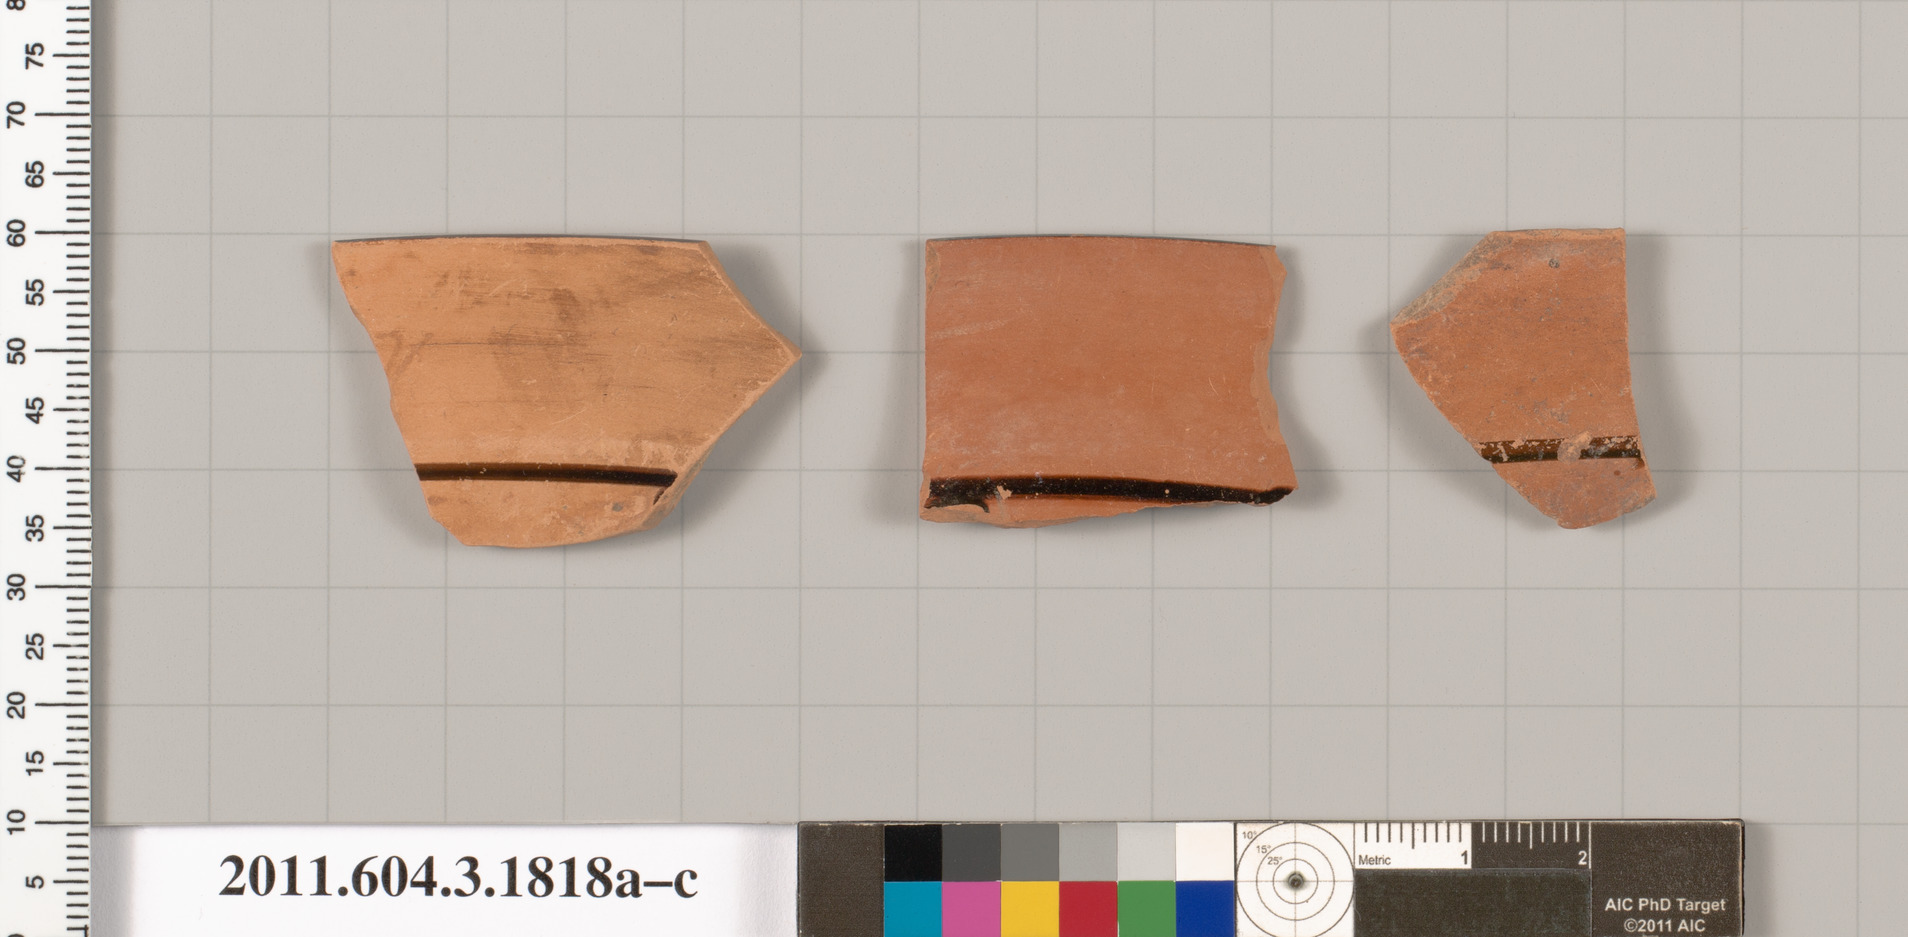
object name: kylix fragment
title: Terracotta rim fragments of kylikes: Lip cup (drinking cup)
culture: greek, attic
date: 560-525 BCE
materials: terracotta